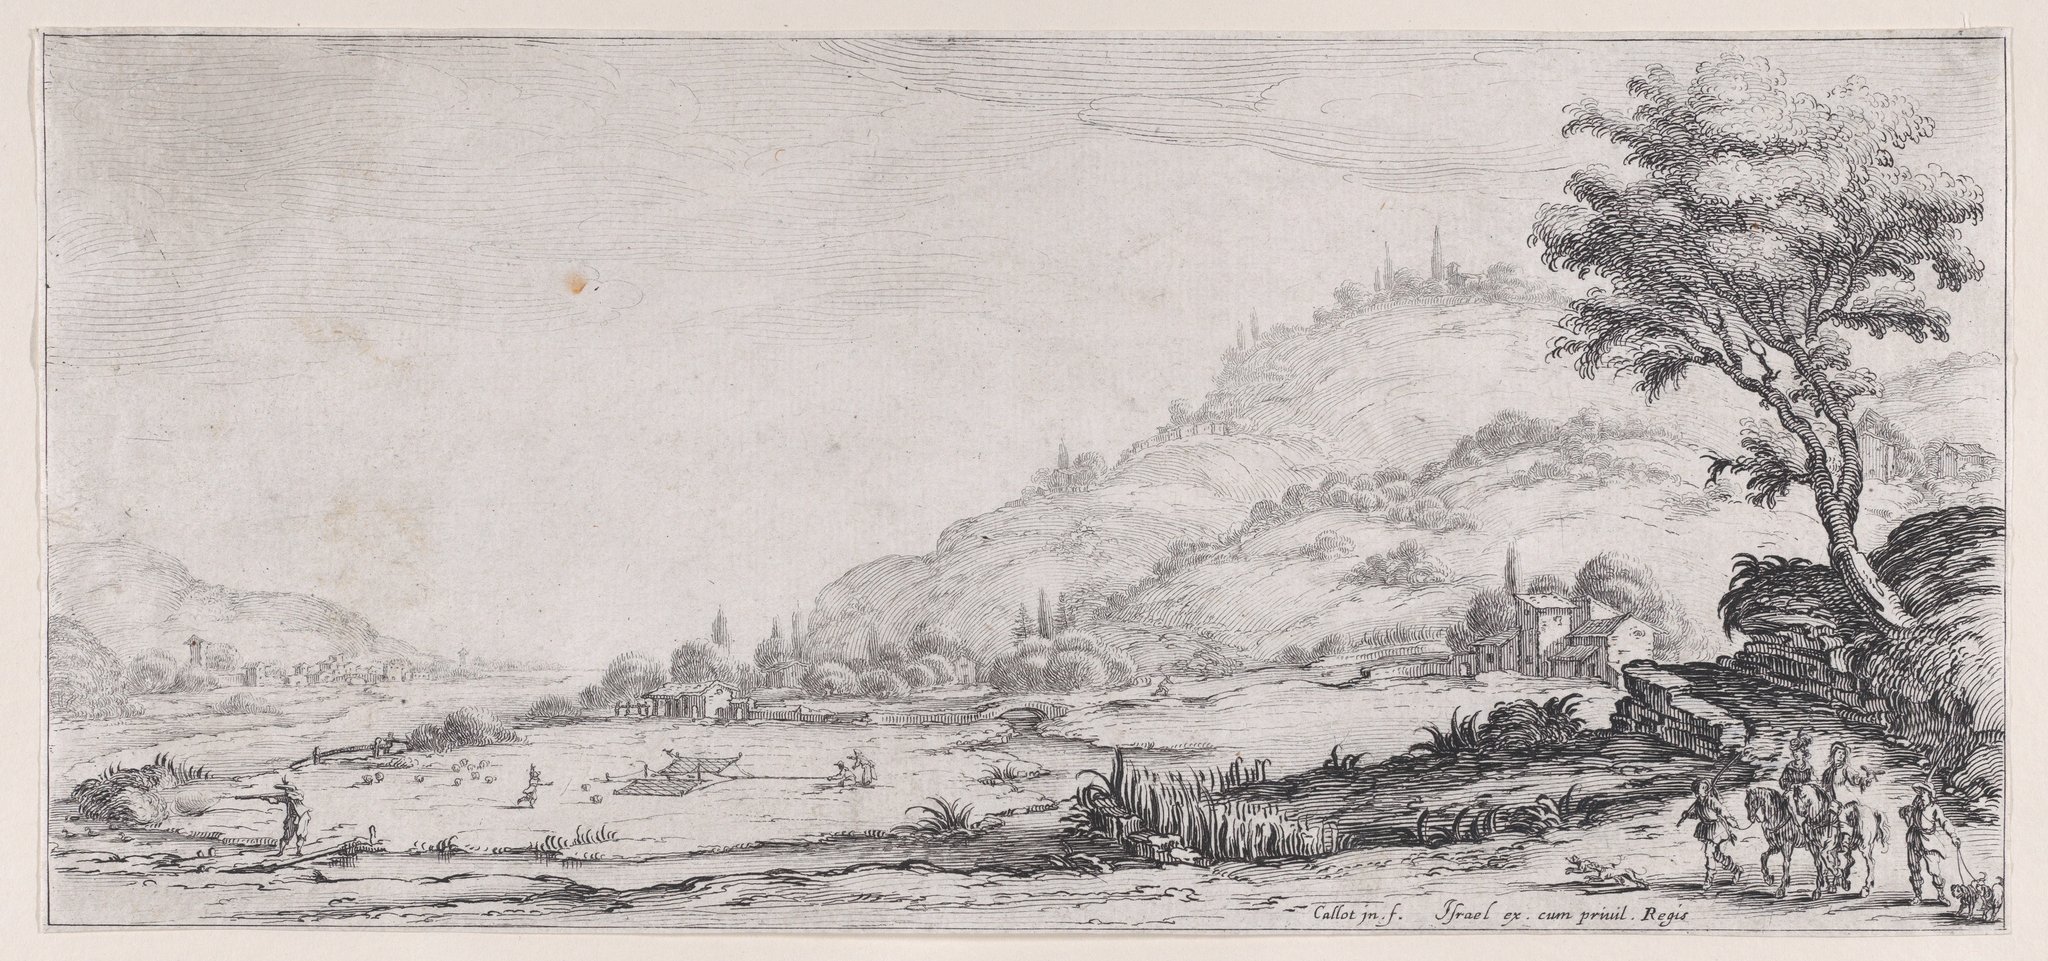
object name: print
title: Le Chasse aux Oiseaux (The Bird Hunt), from "Paysages Gravés pour Jean de Médicis appelées aussi Paysages Dessinés a Florence, Vues de Florence, Paysages d'Italie, et Paysages Définitifs" (Landscapes Engraved for Giovanni de'Medici, Landscapes Designed in Florence, Views of Florence, Landscapes of Italy, and Definitive Landscapes)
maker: jacques callot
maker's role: artist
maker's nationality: french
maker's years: 1592-1635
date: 1618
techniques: etching